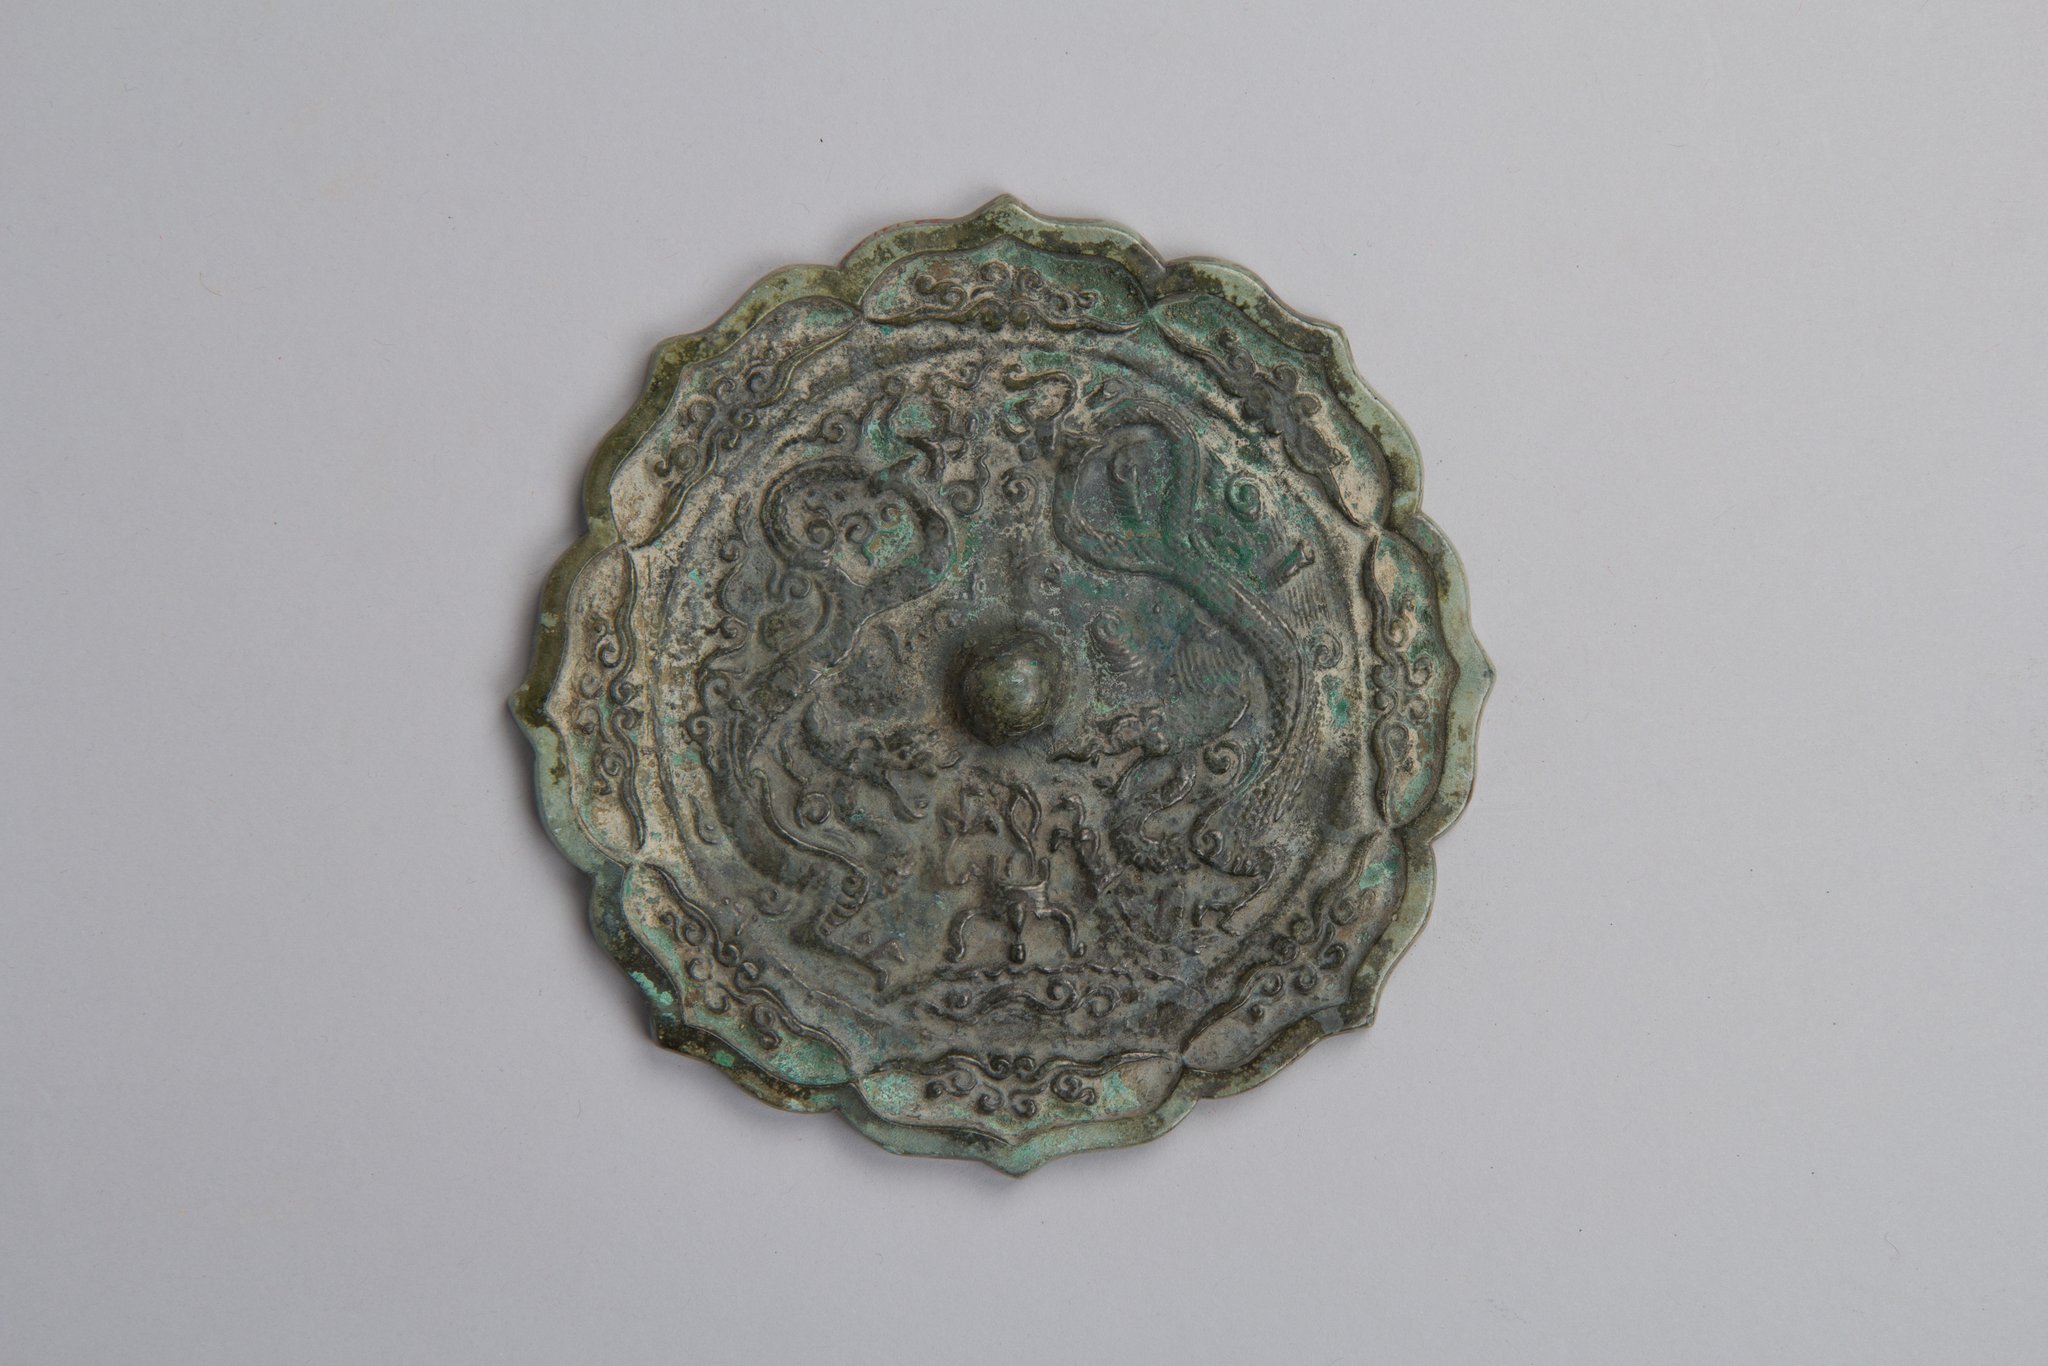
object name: mirror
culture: korean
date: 918-1392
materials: bronze